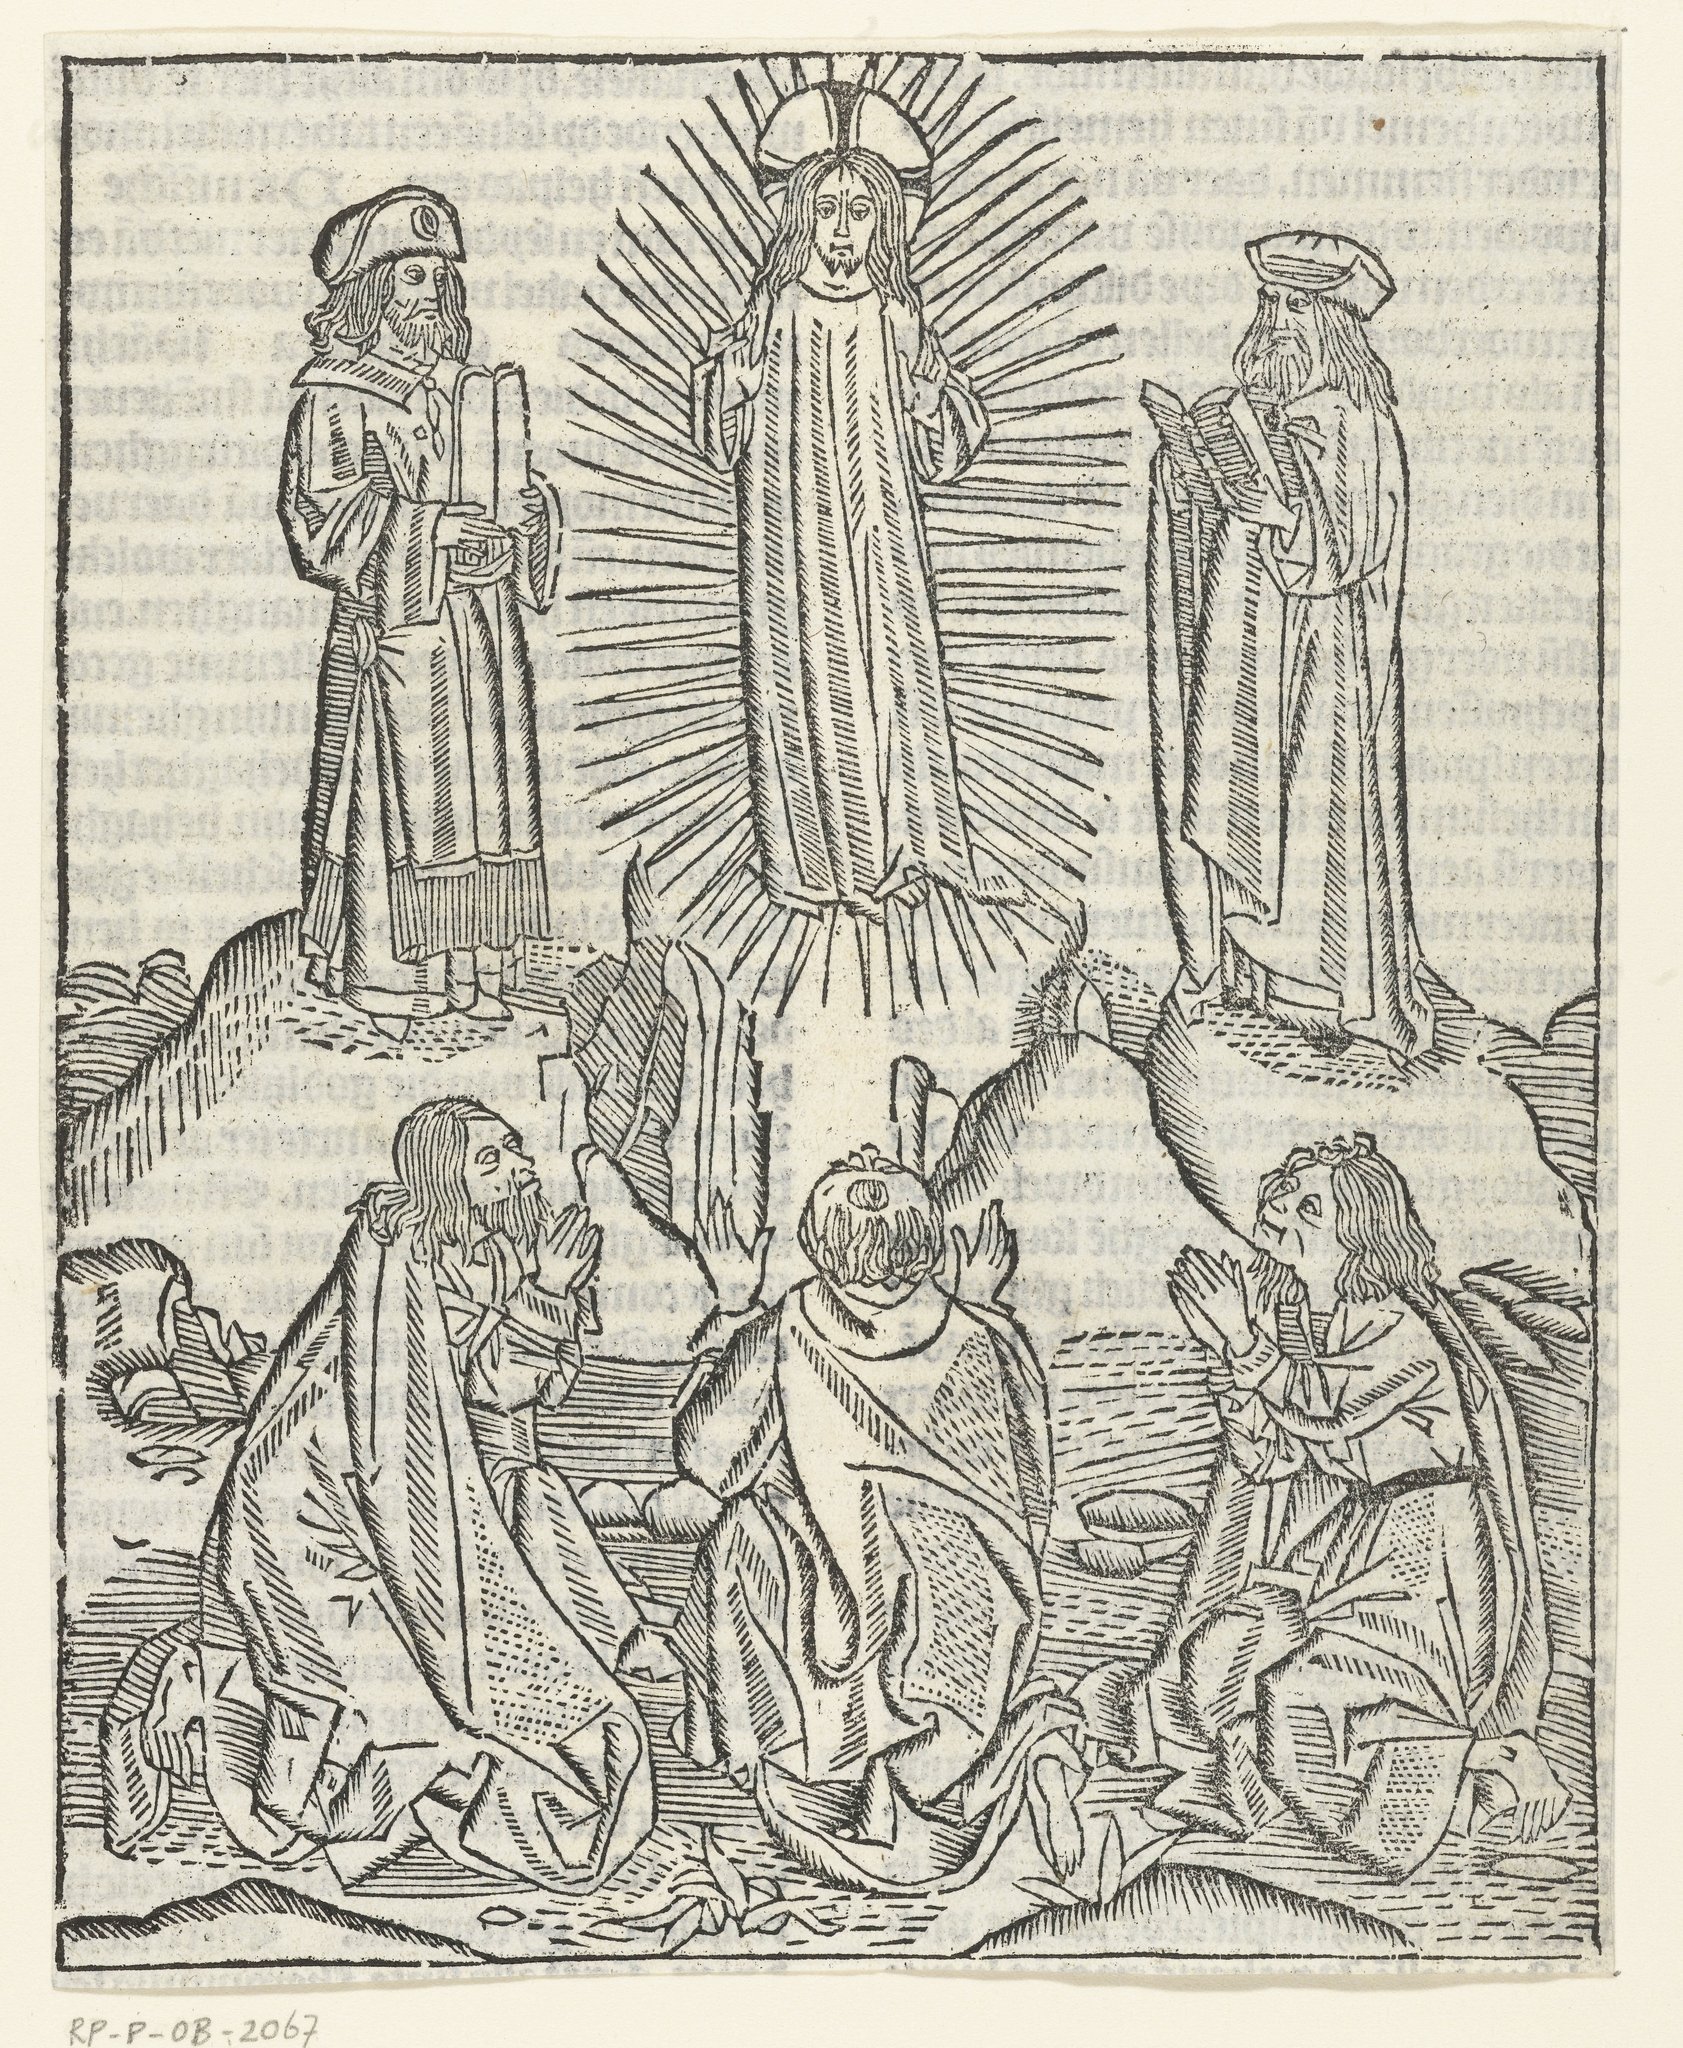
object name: print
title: De transfiguratie van Christus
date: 1480-1500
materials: paper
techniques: woodcut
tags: the transfiguration: moses and elijah appear on either side of christ on mount tabor (matthew 17:1-13; mark 9:2-13; luke 9:28-36)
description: Eén blad van 113 uit Ludolphus de Saxonia, "Dit es dleué ons liefs heeren ihesu christi". Anonieme Nederlandse vertaling. Uitgegeven door Henrick Eckert van Homberch te Antwerpen in 1503. Botke, K. Deze 113 houtsneden, die meestal reeds in vroege Nederlandse boeken gebruikt zijn, worden toegeschreven aan de tweede Meester van Delft, de Meester van de Delbecq-Schreiber-passie en de Meester van de Virgo inter Virgines. In Conway (1884) en in "De gulden passer"(1951) zijn ook eerdere versies opgenomen. Botke, K.